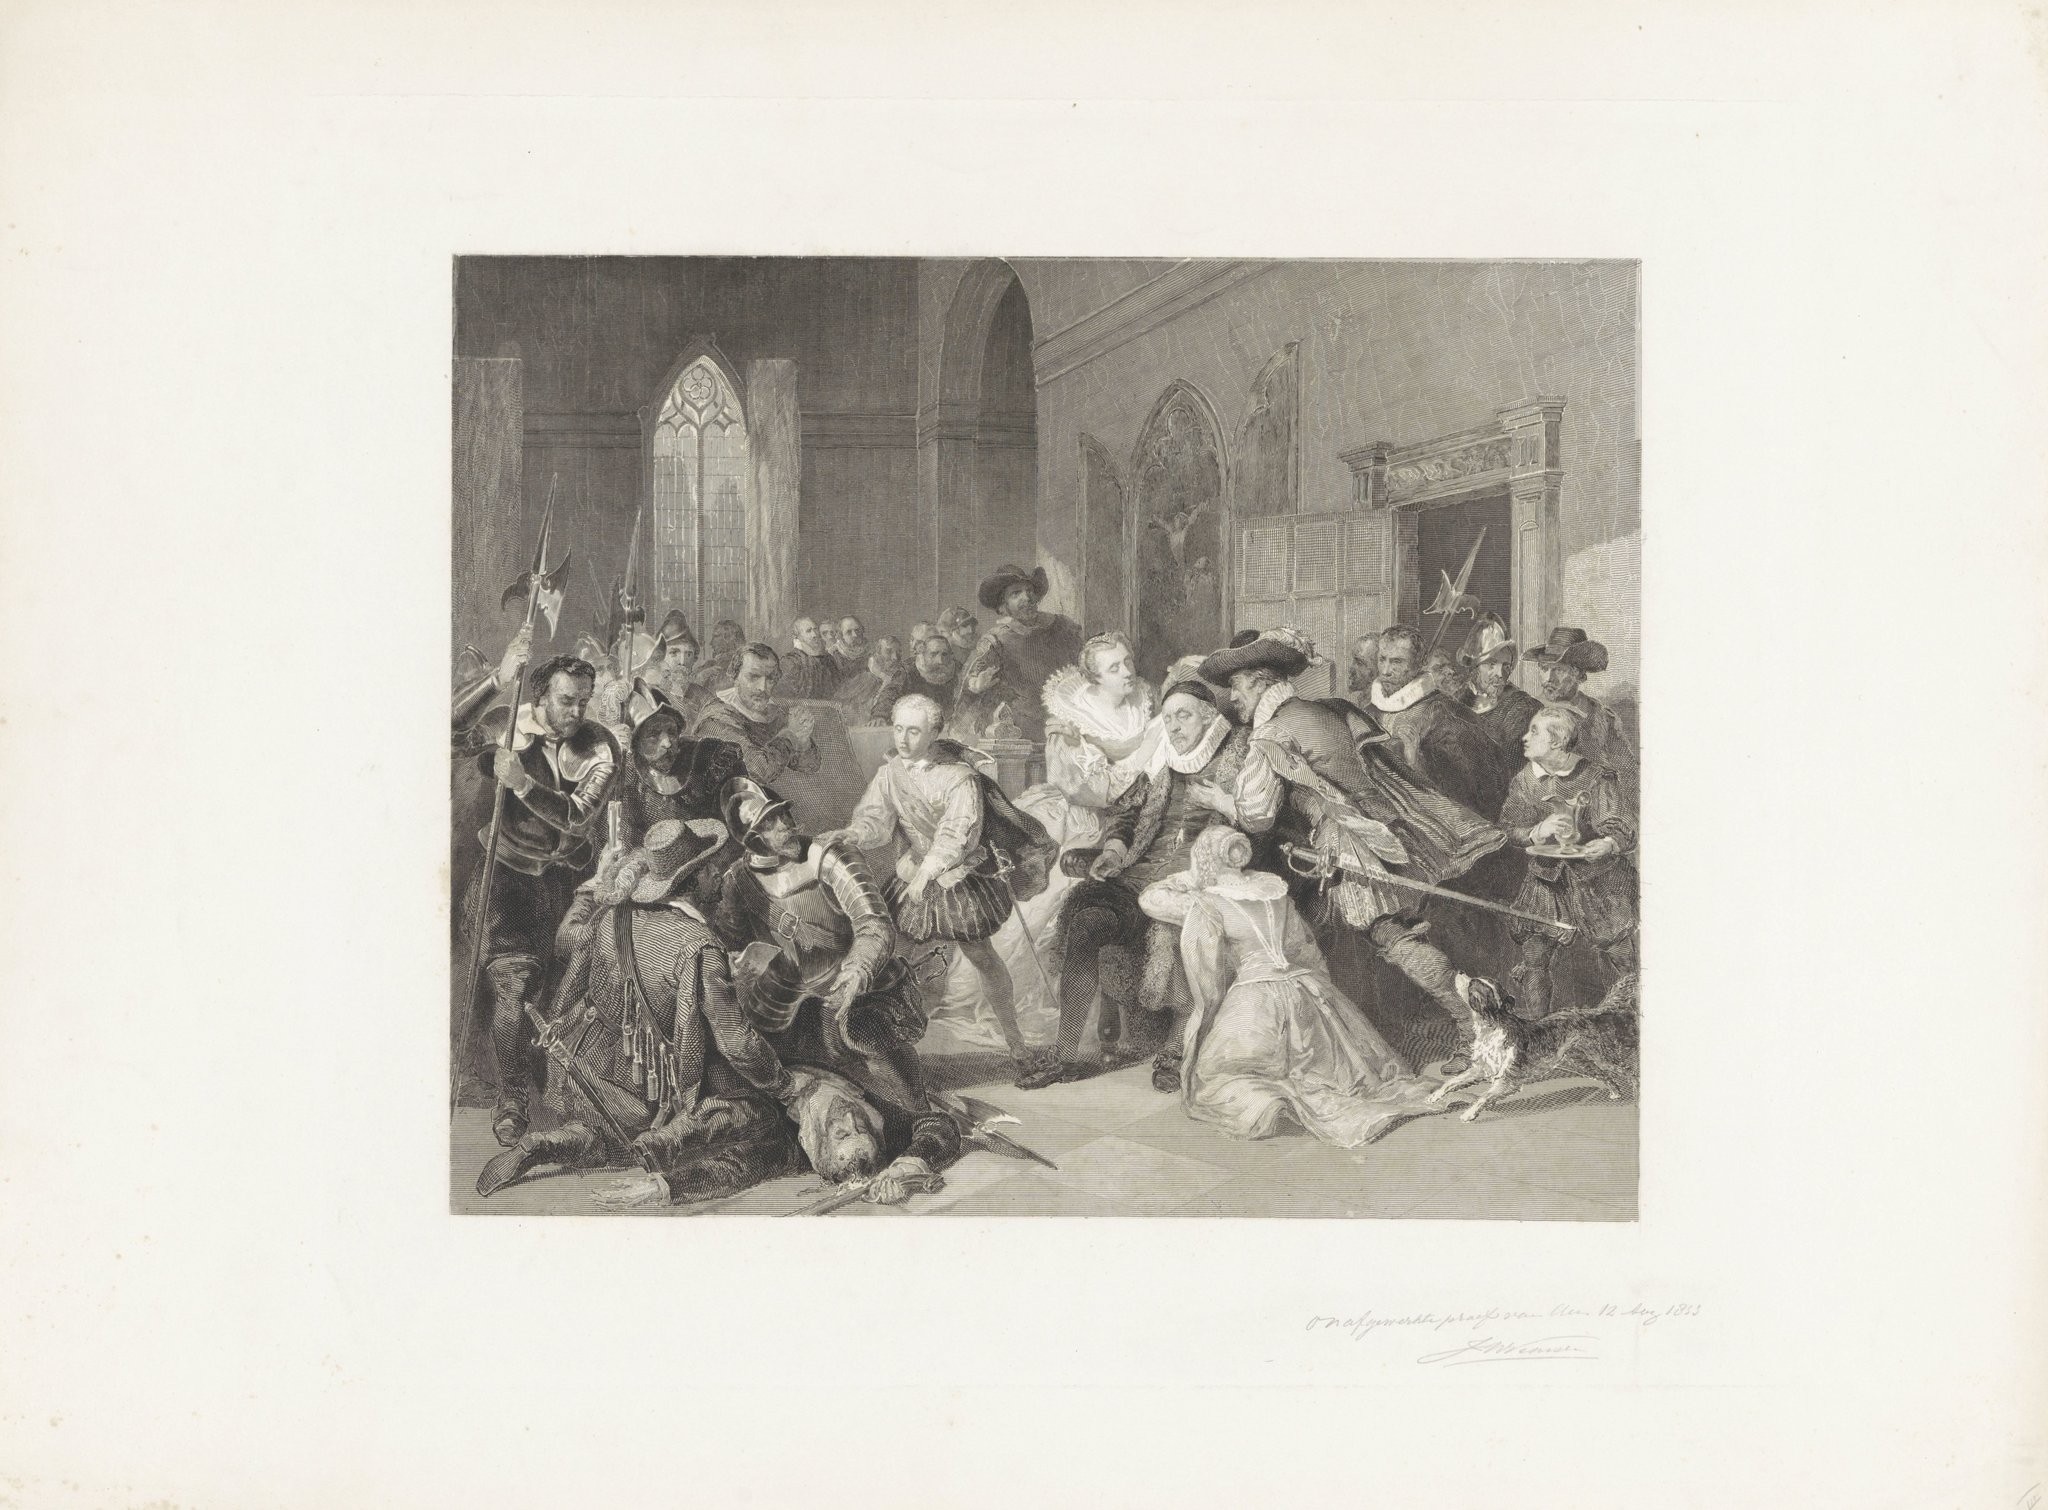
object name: print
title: Aanslag van Jean de Jauregui op prins Willem I, 18 maart 1582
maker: johann wilhelm kaiser (i)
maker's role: draughtsman, print maker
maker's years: 1813-1900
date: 1853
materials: paper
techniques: engraving, etching, roulette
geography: amsterdam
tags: charlotte of bourbon, william i (prince of orange), the hague, maurice (prince of orange), recovery, convalescence of sick person, antwerp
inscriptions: inscription: ‘onafgewerkte proef van [...] 12 Aug 1833 / JW Kaiser’, collector's mark: Lugt 2228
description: Aanslag van Jean de Jauregui op prins Willem I, 18 maart 1582 te Antwerpen. Interieur met de prins die gewond in een stoel zit, met familie en anderen om zich heen. Links op de vloer ligt het lichaam van de gedode Jean de Jauregui. Maurits vraagt de soldaten hem te onderzoeken.